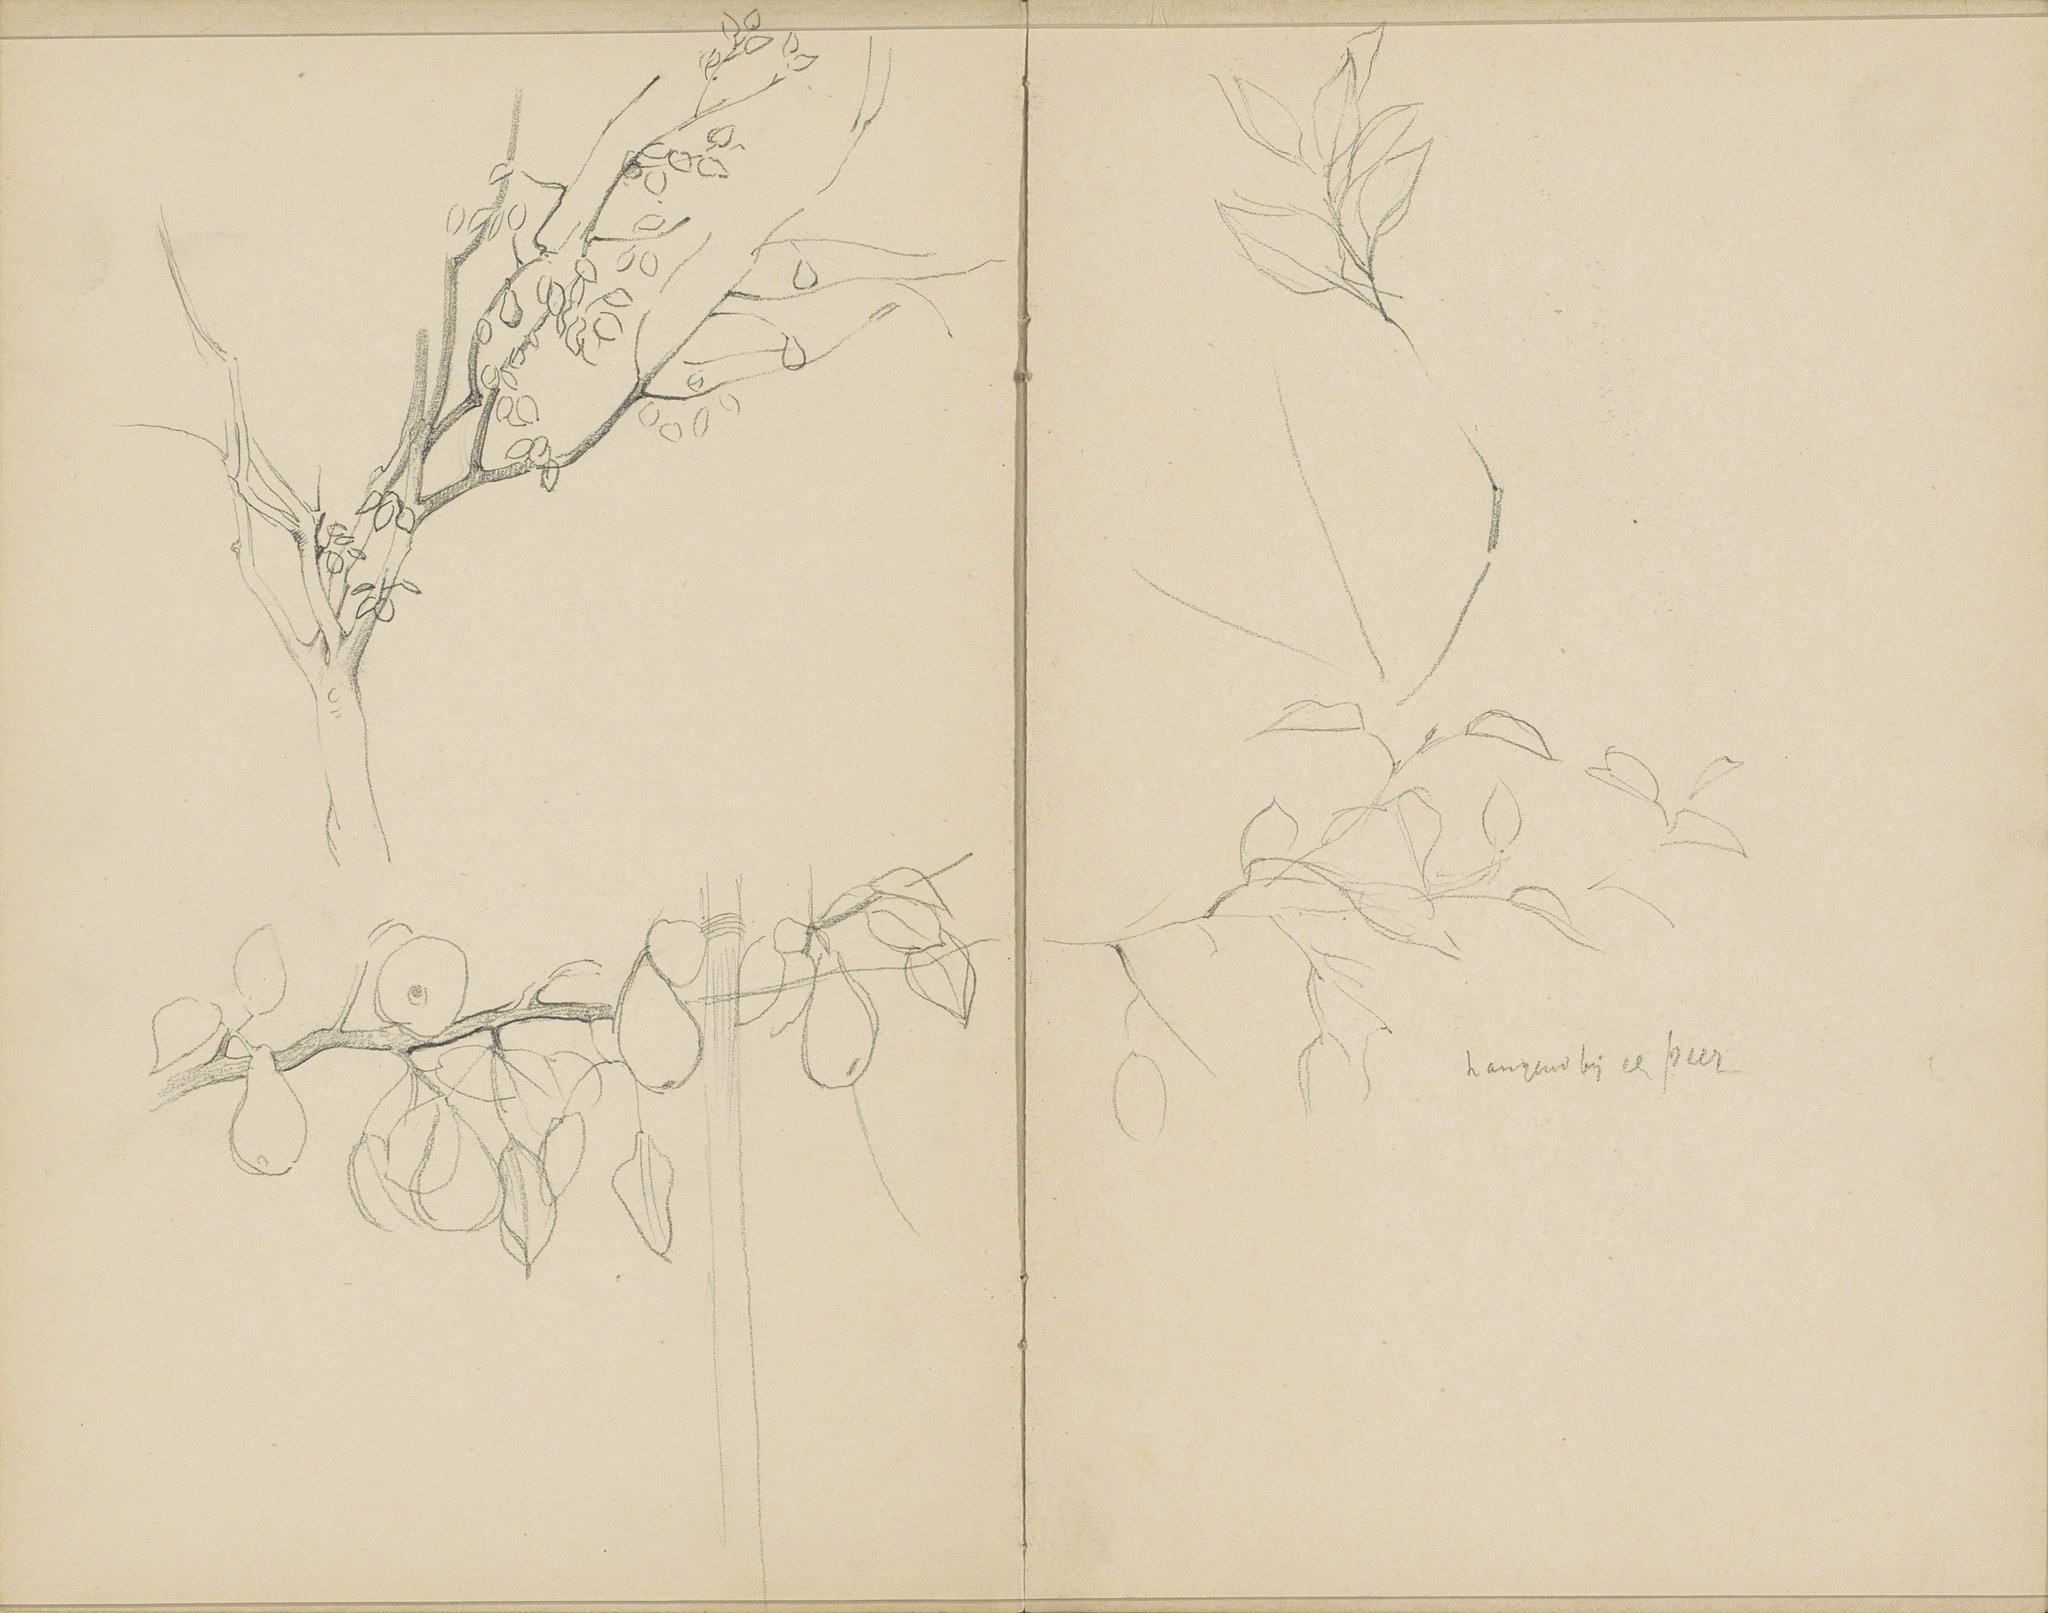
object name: sketchbook leaf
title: Boom in blad en een tak met peren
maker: antoon derkinderen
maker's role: draughtsman, painter, print maker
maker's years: 1859-1925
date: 1889-1894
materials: paper, pencil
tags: trees (+ leaf), fruits: pear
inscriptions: annotation: ‘hangend bij [...] peer’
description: Blad 10 verso en 11 recto uit een schetsboek met 33 bladen.